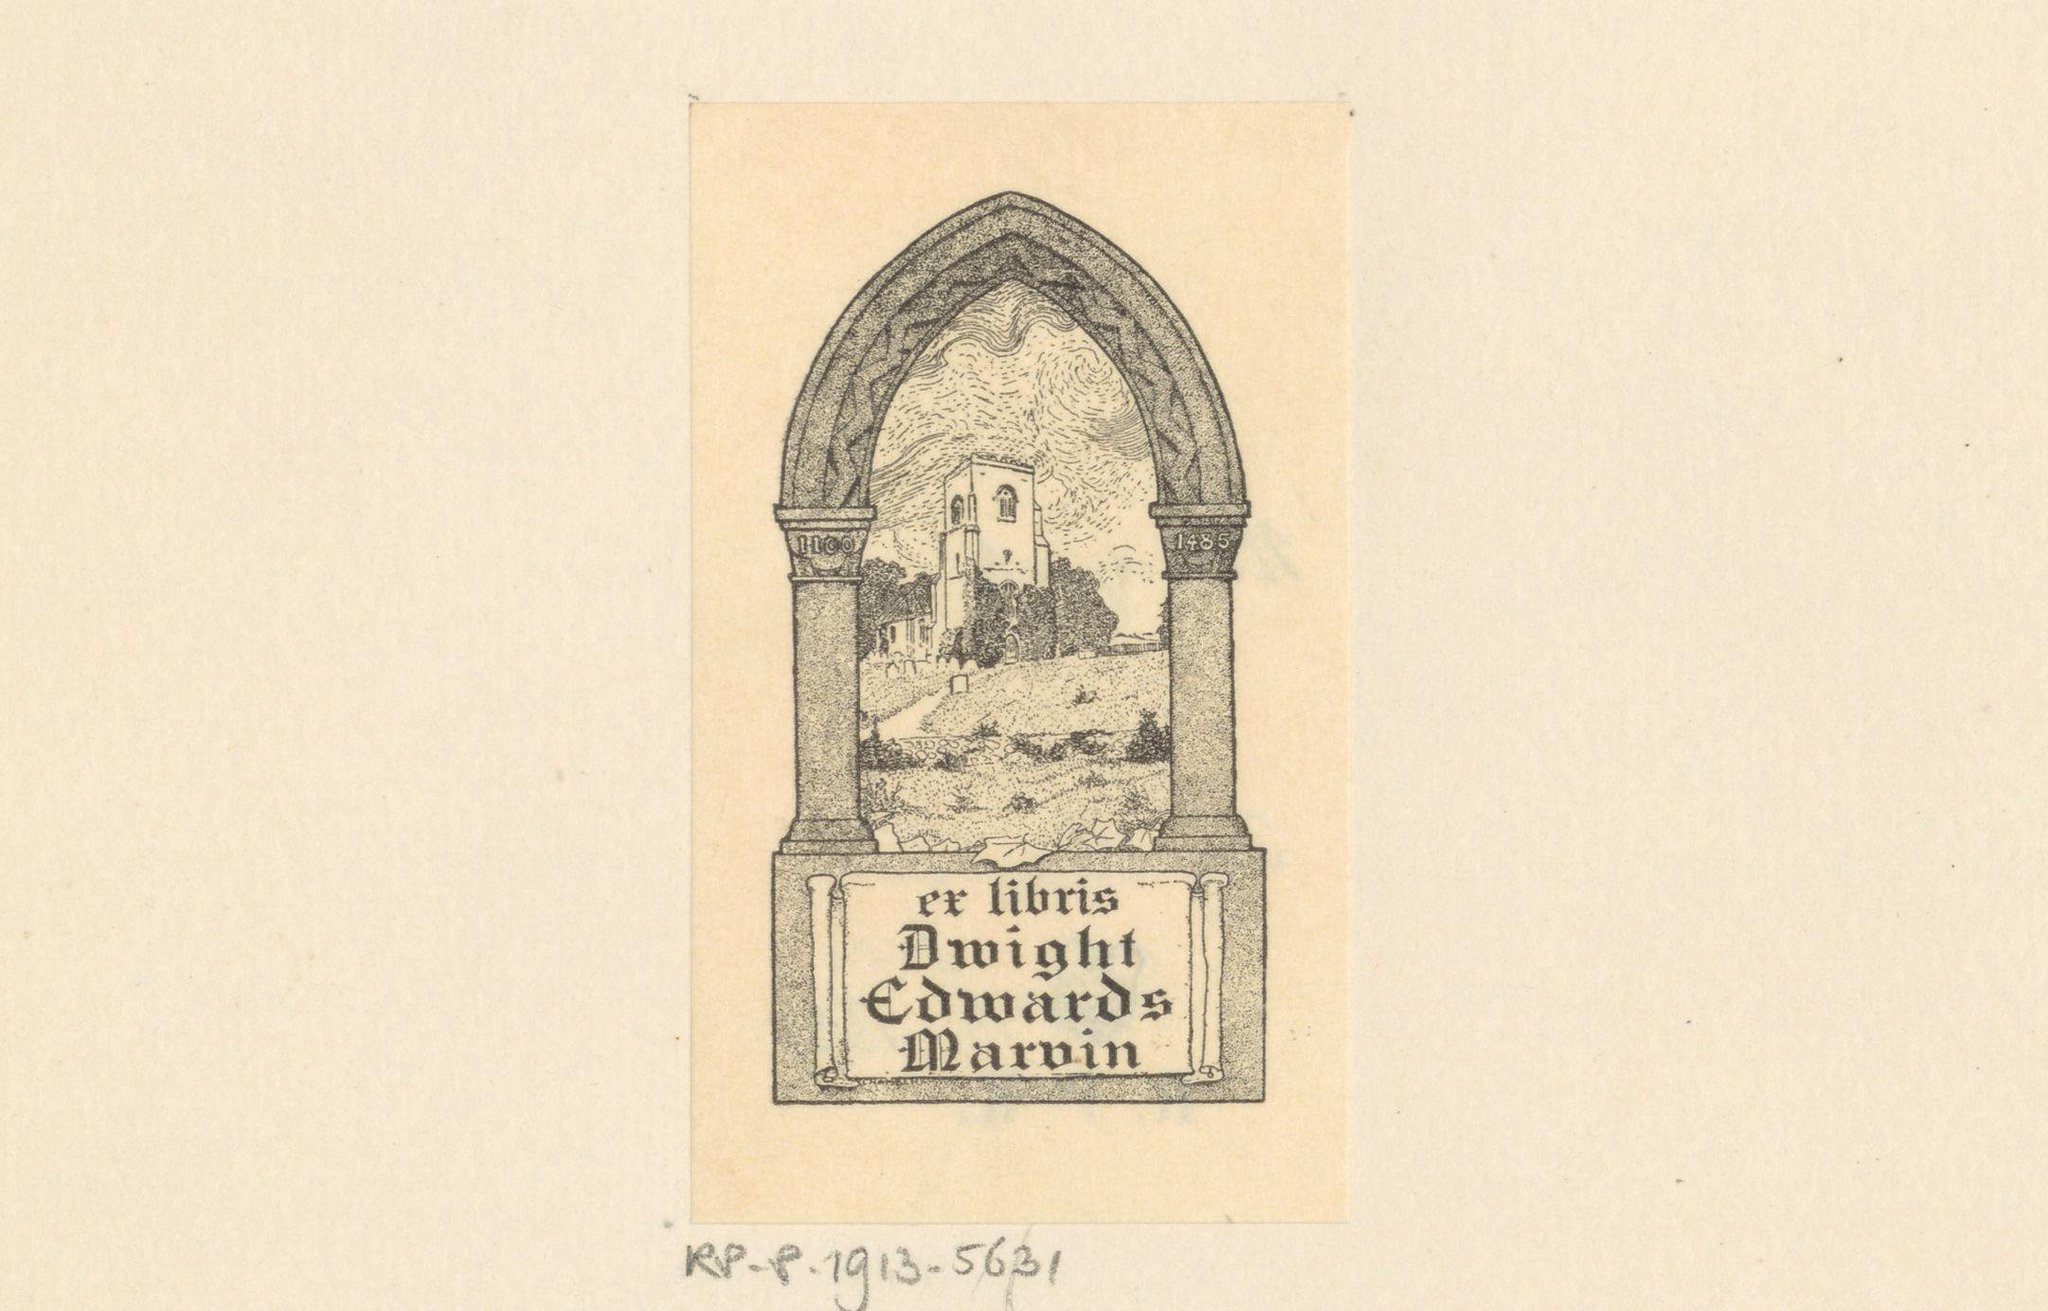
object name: bookplate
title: Ex libris van Dwight Edwards Marvin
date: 1887-1913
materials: paper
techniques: printing block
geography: north and central america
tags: saints, arch, archivolt ~ architecture, church (exterior)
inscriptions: collector's mark: Lugt 2233, collector's mark: Lugt 2760